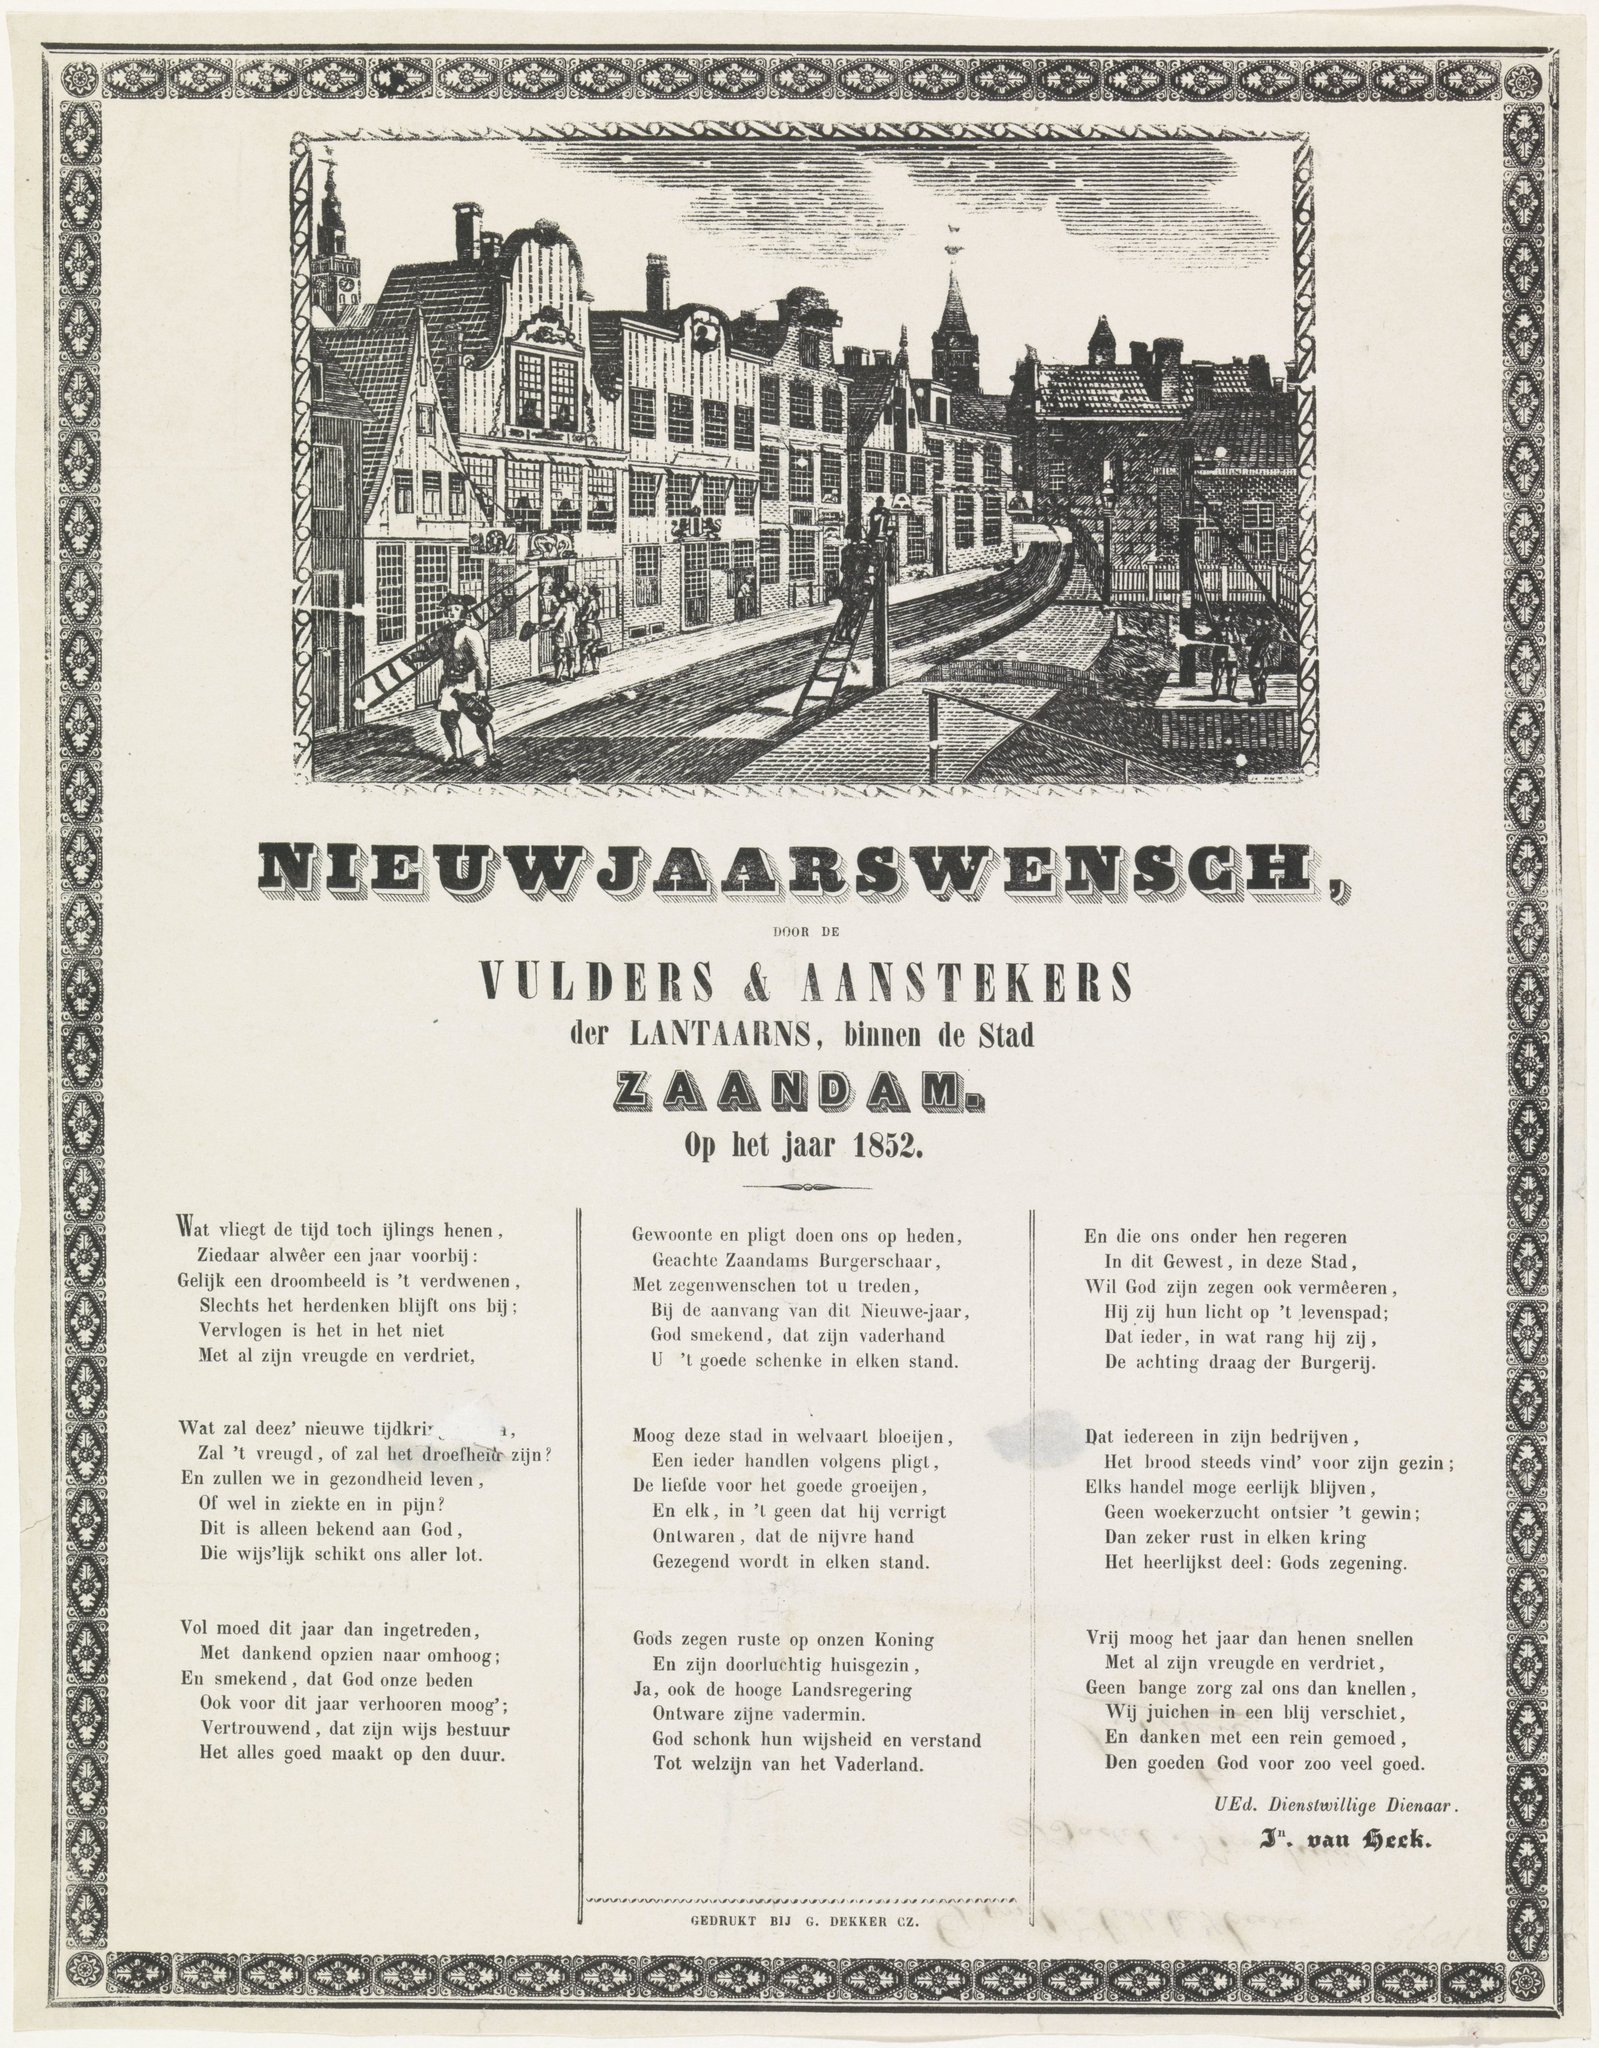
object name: print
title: Nieuwjaarswensch, Door de Vulders & Aanstekers der Lantaarns, binnen de Stad Zaandam. Op het Jaar 1852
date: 1851-1852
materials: paper, wax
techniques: letterpress printing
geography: netherlands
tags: oil-lamp (+ kindling a light; lit, burning light, lamp, candle), street lighting, street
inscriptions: collector's mark: Lugt 2228, inscription: ‘Den Weledele Heer Bodel Nijenhuis te Leiden’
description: Nieuwjaarswens van de lantaarnopstekers van Zaandam voor het jaar 1852. Enkele lantaarnopstekers met ladders aan het werk in een straat in Zaandam. Twee mannen halen bij een huis geld op. Binnen een omlijsting van fileetwerk. Onderaan een vers in drie kolommen. Namens de lantaarnopsteker: Jn. van Heek.